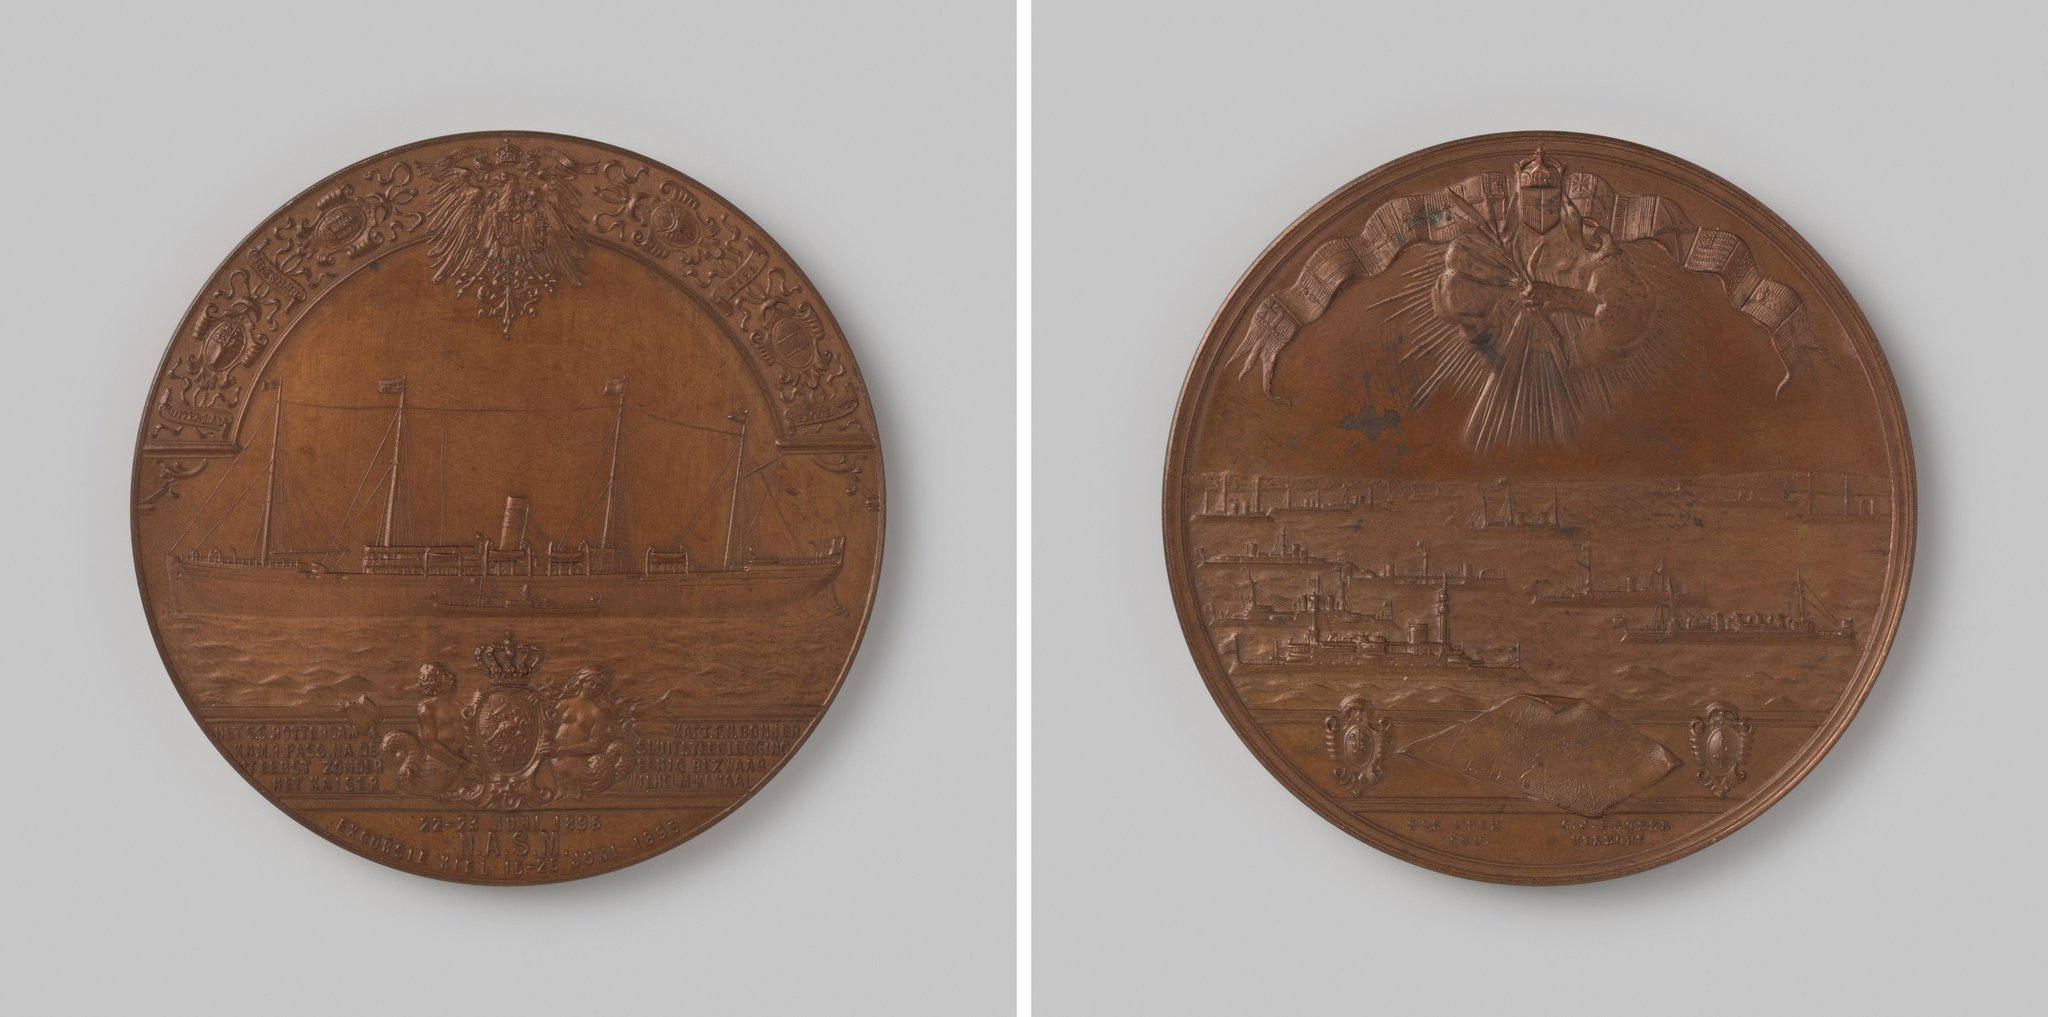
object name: history medal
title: Opening van het Kieler Kanaal 1895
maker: bas veth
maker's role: designer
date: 1895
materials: bronze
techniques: striking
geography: utrecht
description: Bronzen penning, op de voorzijde de SS Rotterdam varend naar links onder een versierde rand met wapenschilden, met onderaan een band met vier regels tekst waarop een gekroond ovaal Nederlands wapenschild gehouden door een zeemeerman en -min, met afsnedetekst, op de keerzijde het kanaal vol schepen onder een stralende wolk waarop een hand met palmtak, een lint met vlaggen en een gekroond wapenschild, met onderaan een band waaarop twee cartouches en een landkaart.